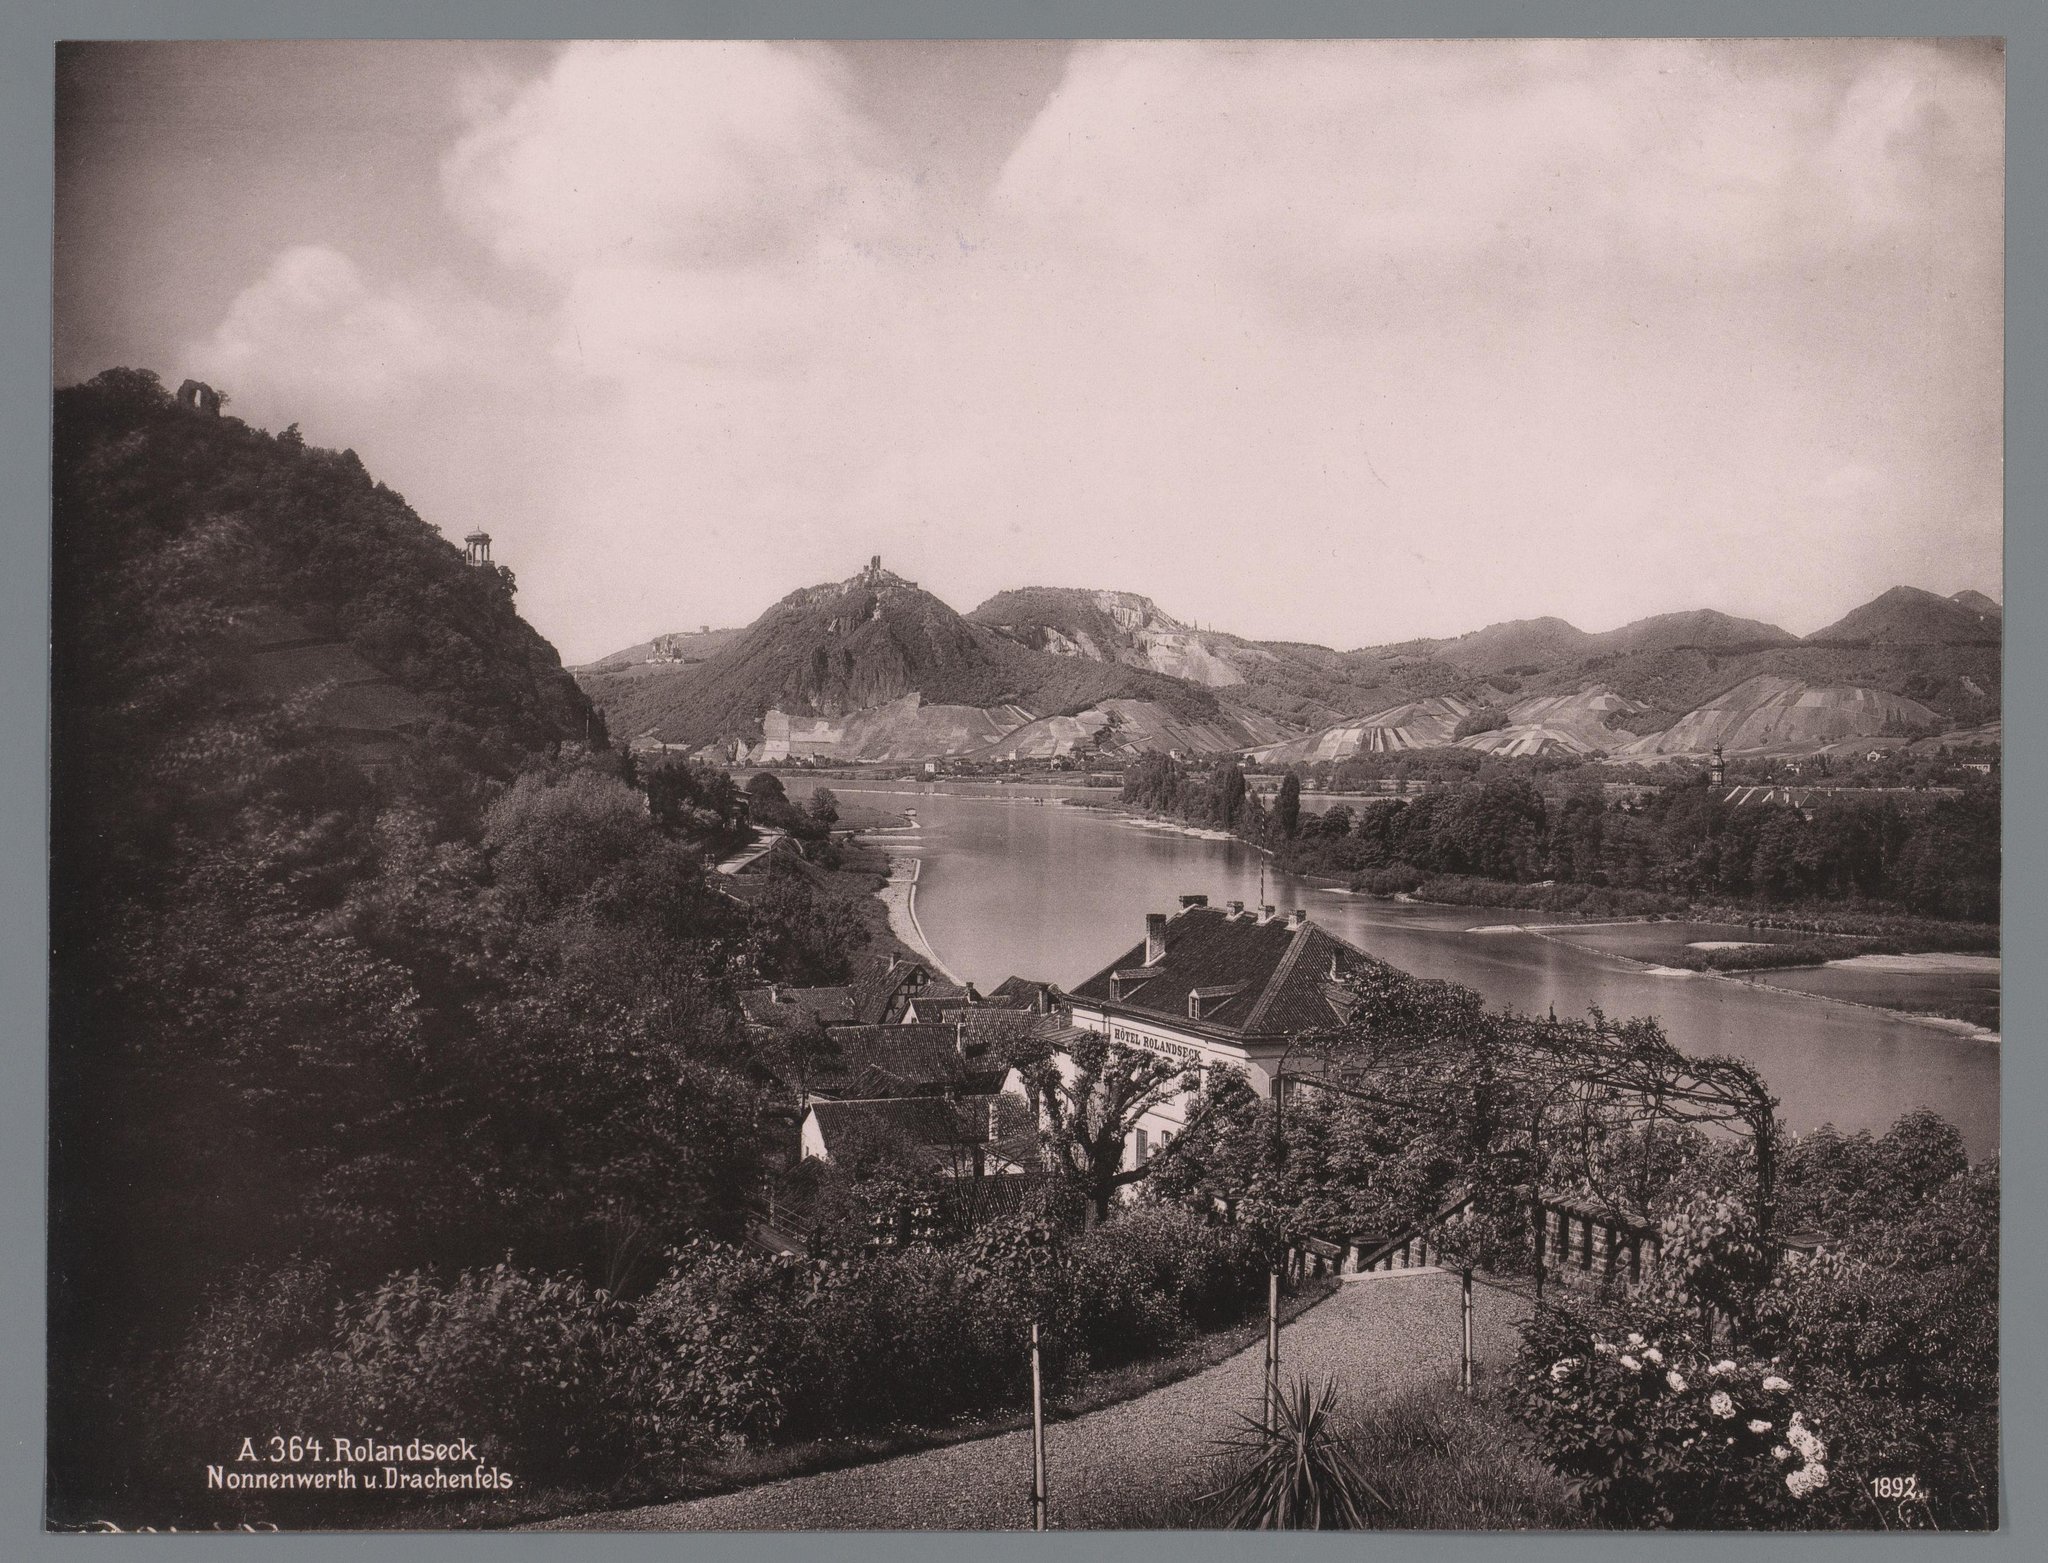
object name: photomechanical print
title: Rolandseck, Nonnenwerth u. Drachenfels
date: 1892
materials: paper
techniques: photograph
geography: rolandseck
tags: island, river, extinct volcano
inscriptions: number: ‘A. 364.’, stamp: ‘PHOTOGR. AUFNAHME U. AUSFÜHRUNG/ DR. E. MERTENS & CIE BERLIN W. 62./ [...]’, inscription: ‘- ct/ - co[?]’